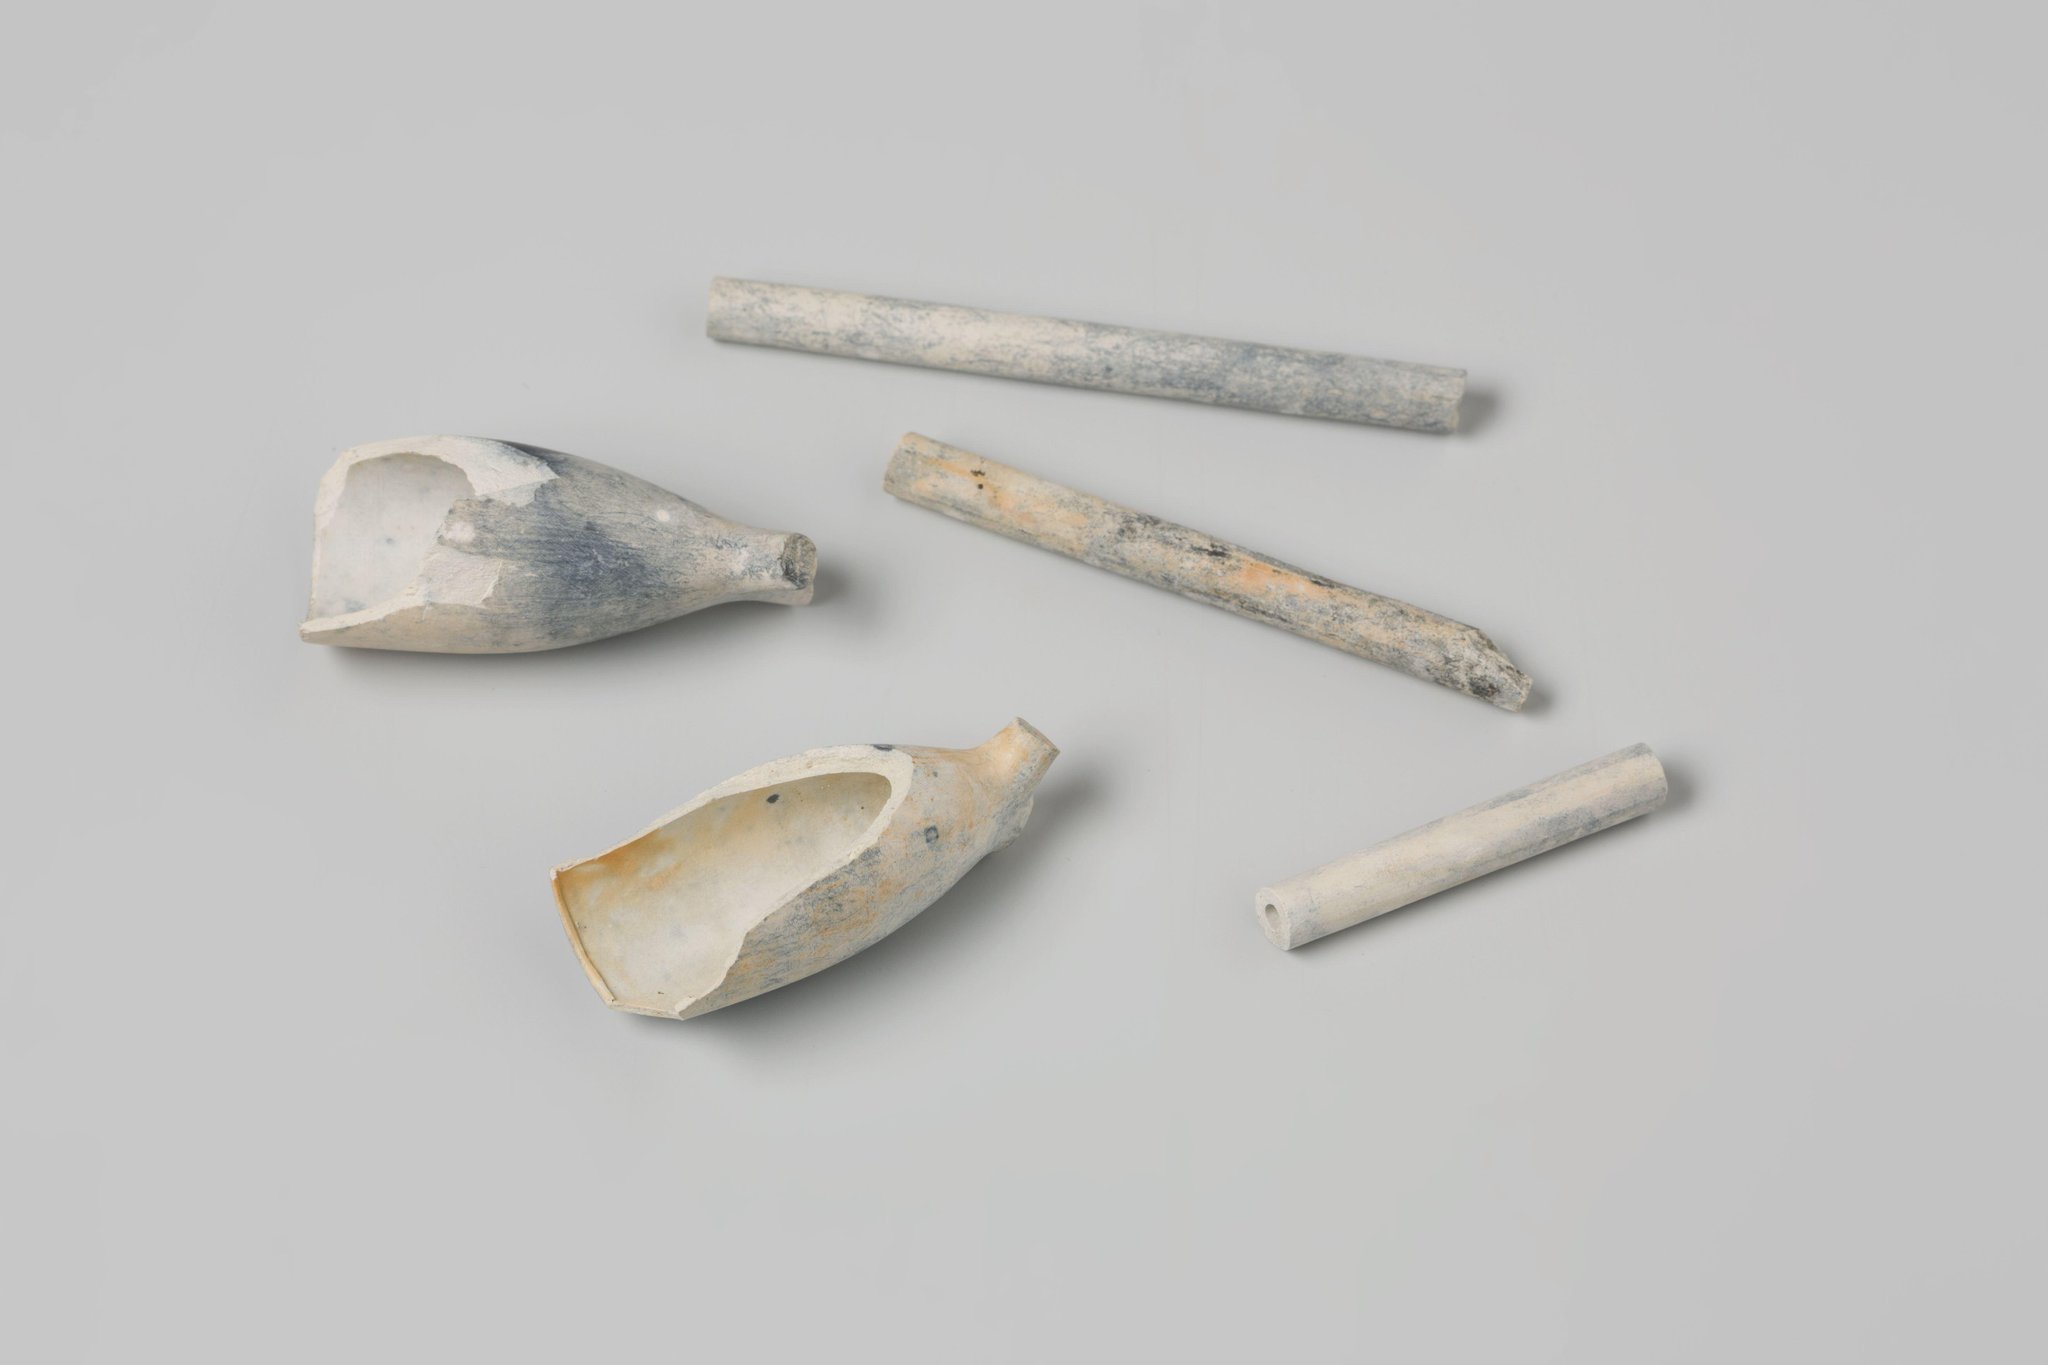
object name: pipe stem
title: Fragmenten van pijpenstelen en pijpenkoppen uit het wrak van de Oost-Indiëvaarder 't Vliegend Hart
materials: clay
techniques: firing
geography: gouda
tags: 't vliegend hart (schip), verenigde oostindische compagnie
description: Twee gebroken koppen van een aarden Goudse pijp, hielmerk WS. Drie stukken steel. Alles blauw-wit. Fragments of bowls and stems.